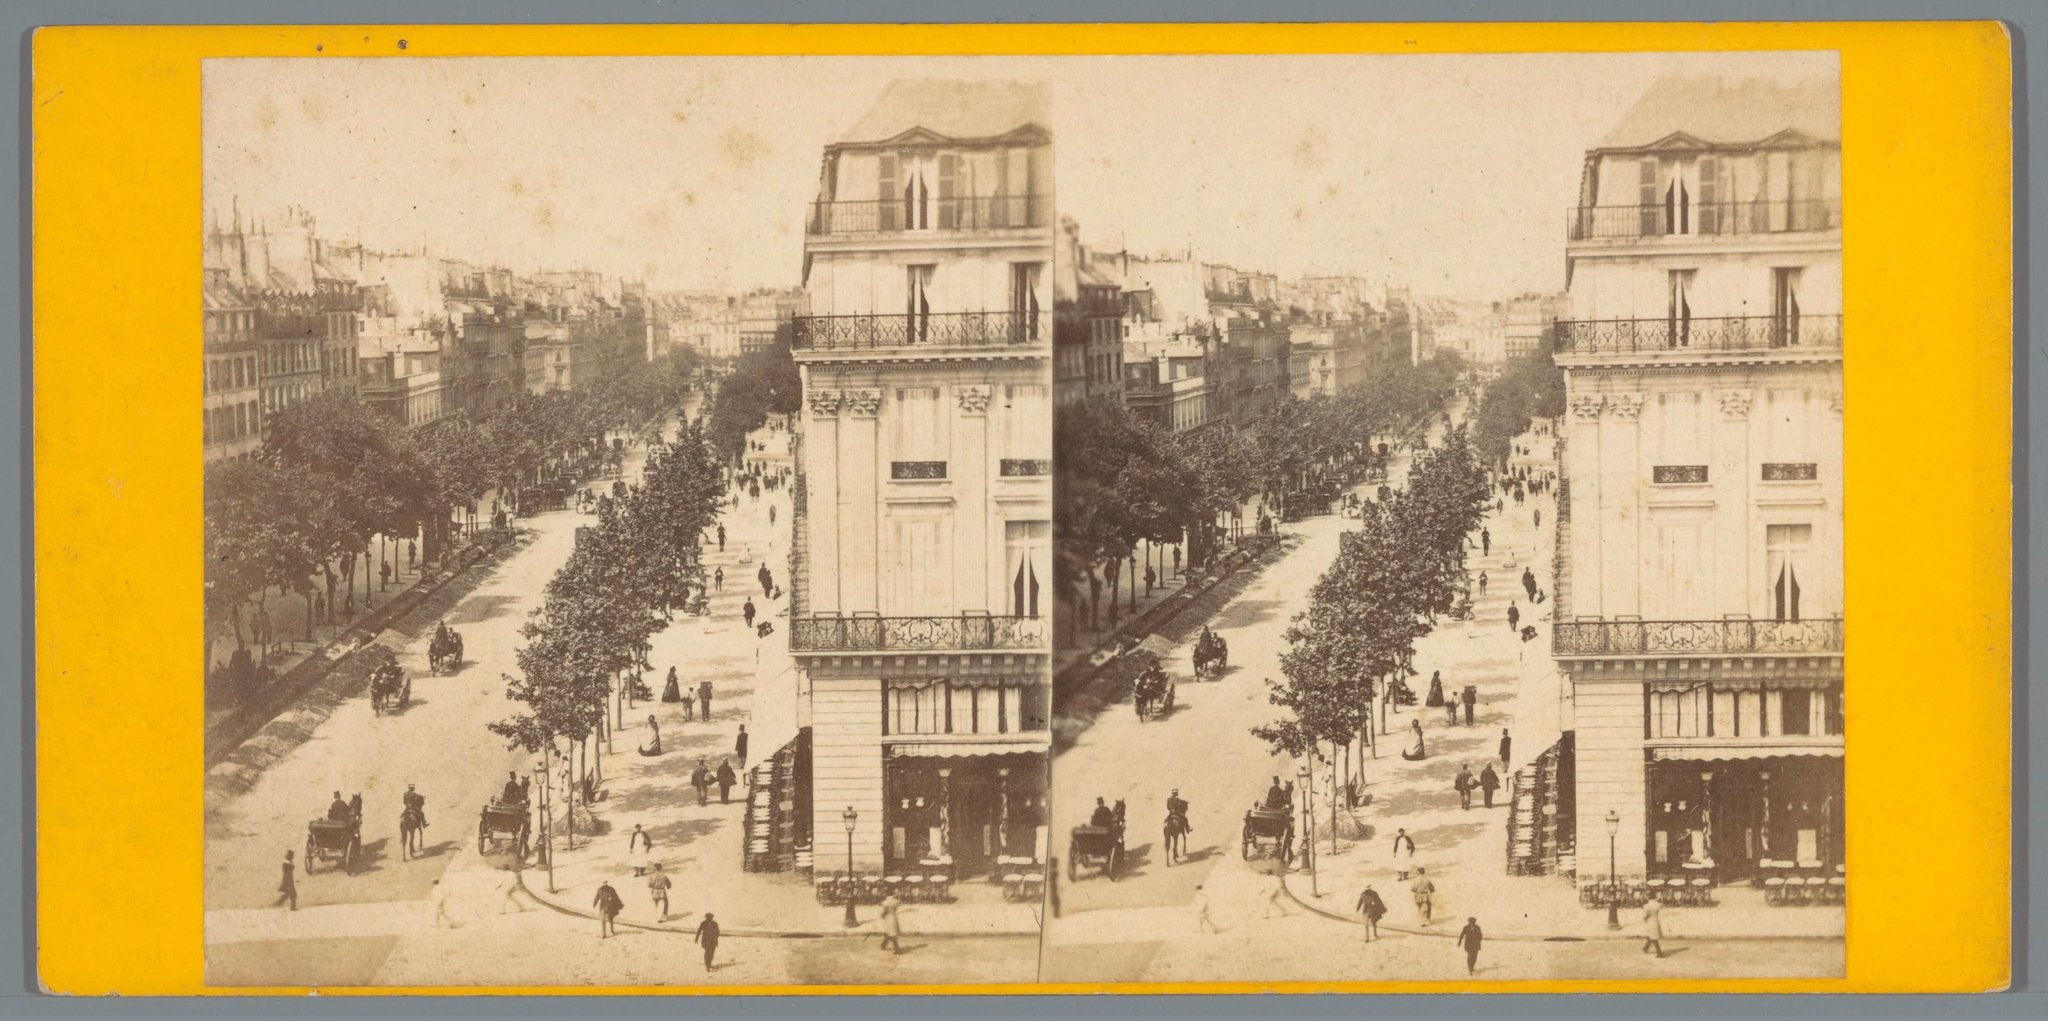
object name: stereograph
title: Boulevart des Capucines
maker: Anonymous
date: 1850-1880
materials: cardboard, photographic support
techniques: albumen print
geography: paris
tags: animal traction, animal-drawn vehicle (carriage etc.), street